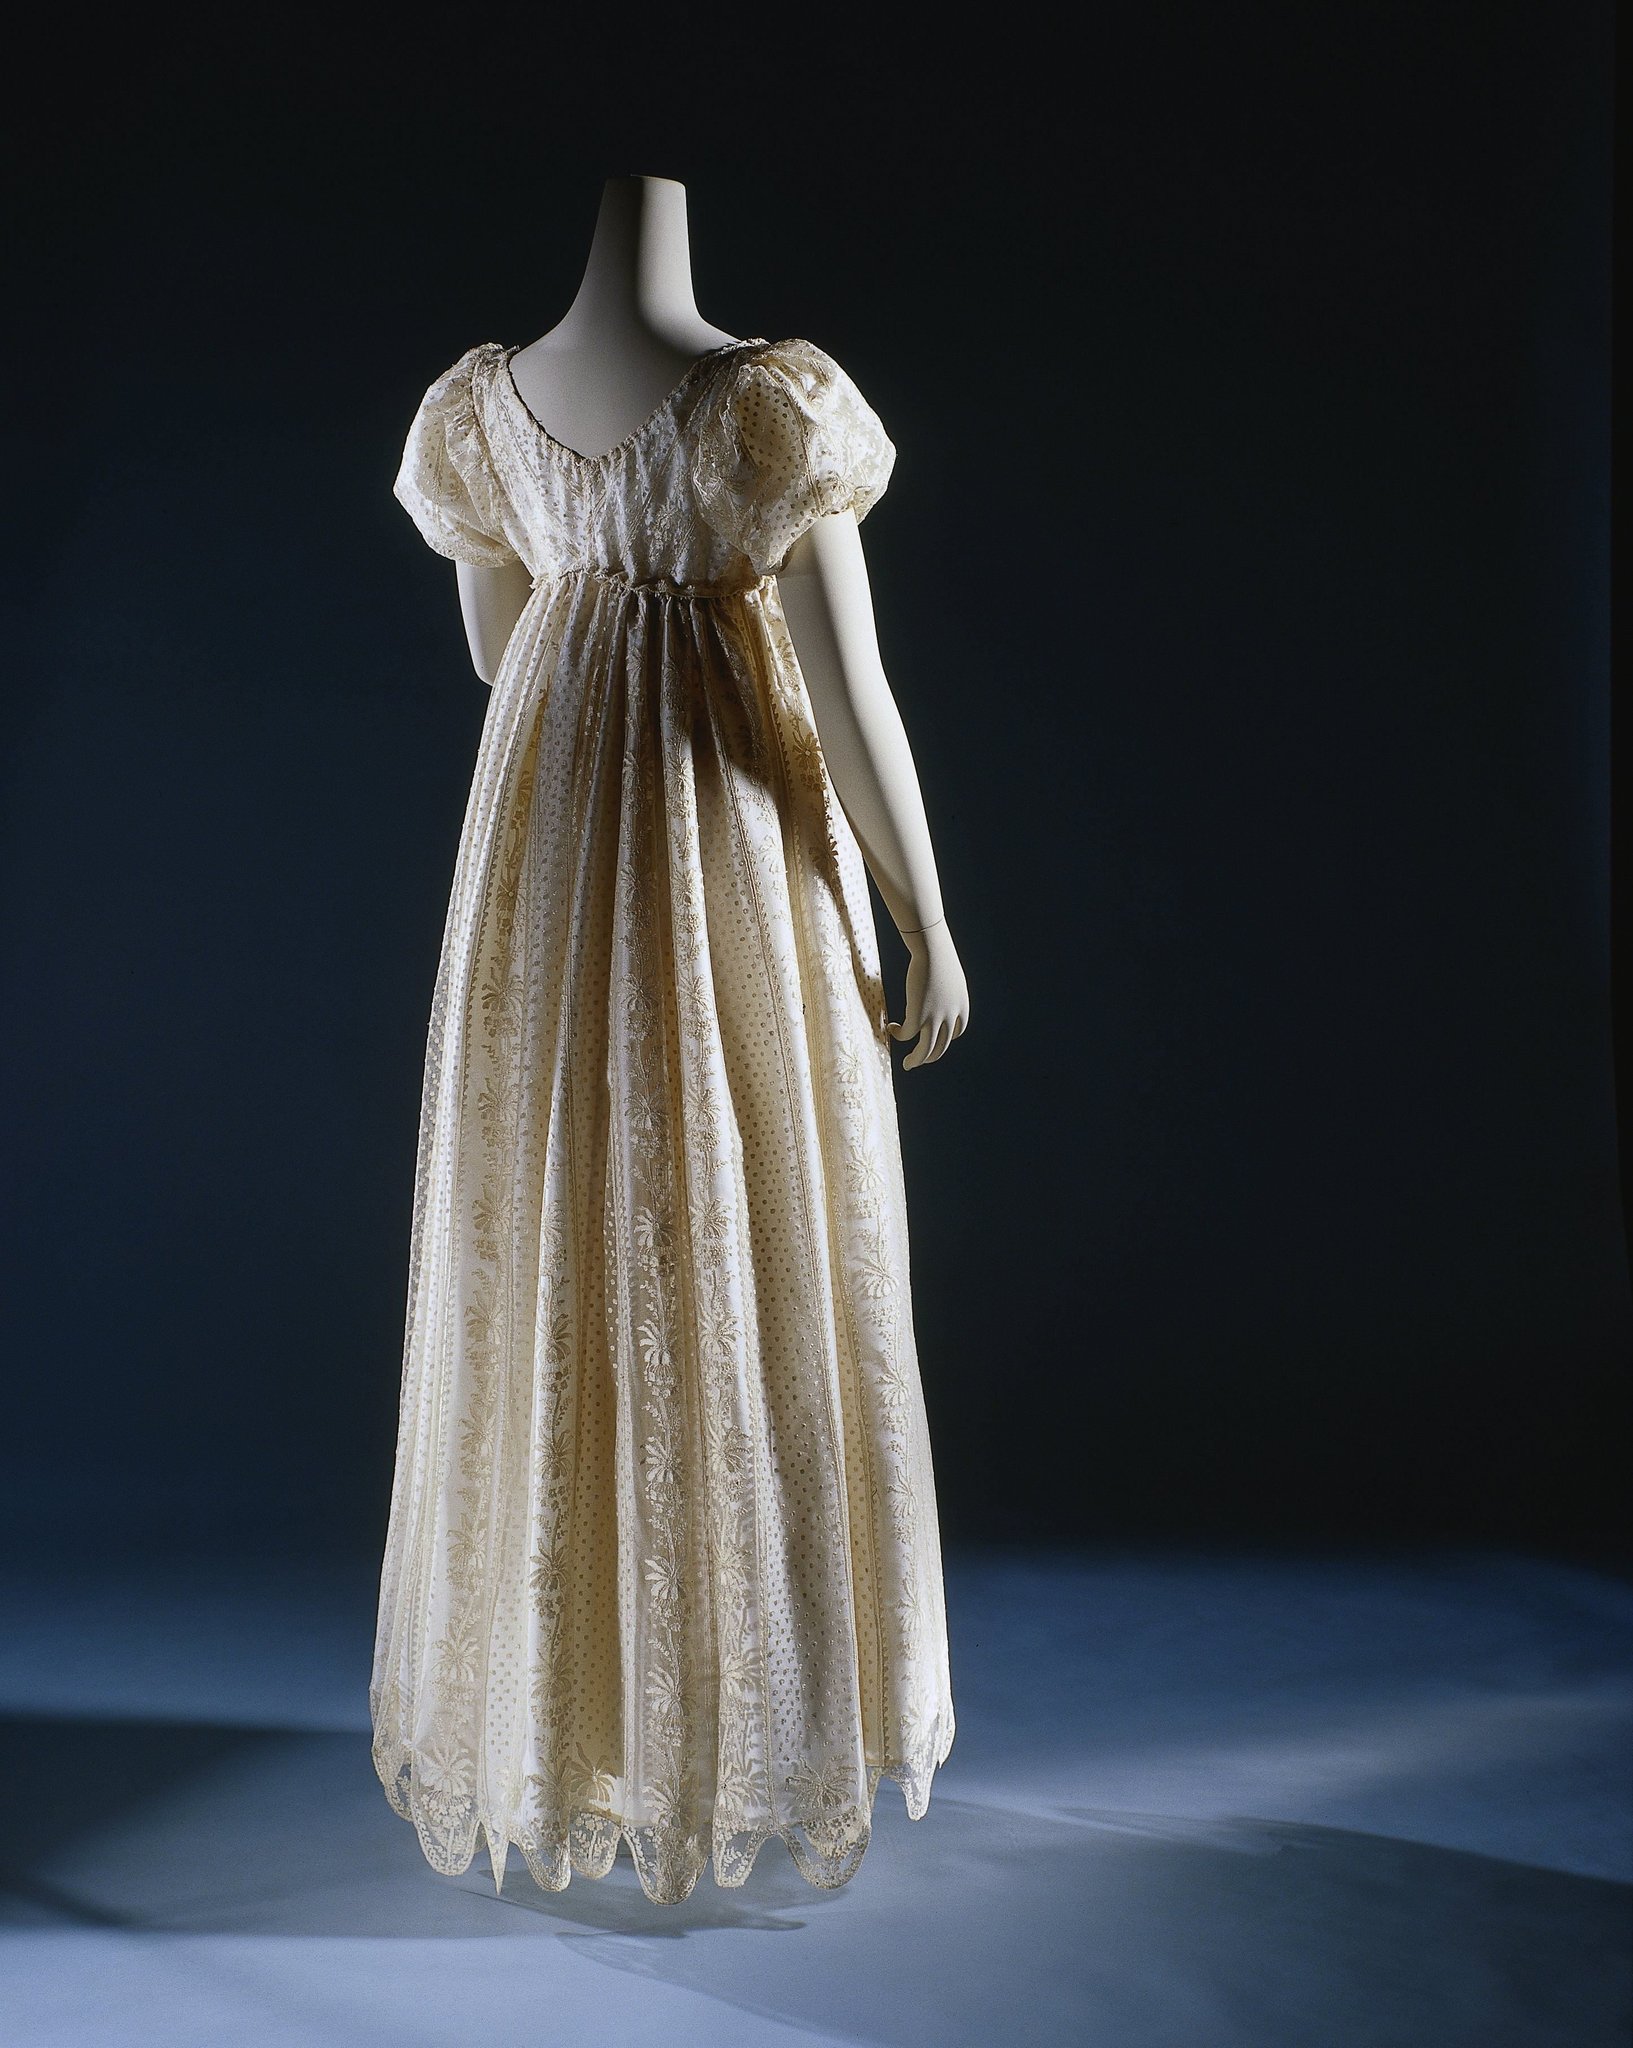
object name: womenswear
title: Japon van zijden kloskant, blonde, met een hoge taille en zeer laag uitgesneden voor- en rugpanden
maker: Anonymous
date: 1805-1825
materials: silk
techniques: lace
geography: france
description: Japon van zijden kloskant, blonde. Hoge taille, zeer laag uitgesneden voor- en rugpanden. Pofmouwen. Kegelvormige rok, van voren glad, van achteren gerimpeld aangezet. Naar beneden in breedte toenemende banen vertonen beurtelings gestrooide sneeuwvlokken en opgaande, aaneengeregen keizerskronen. De rokzoom heeft diepe afgeronde schulpen. In het lijfje zijn de banen kepervormig geplaatst.